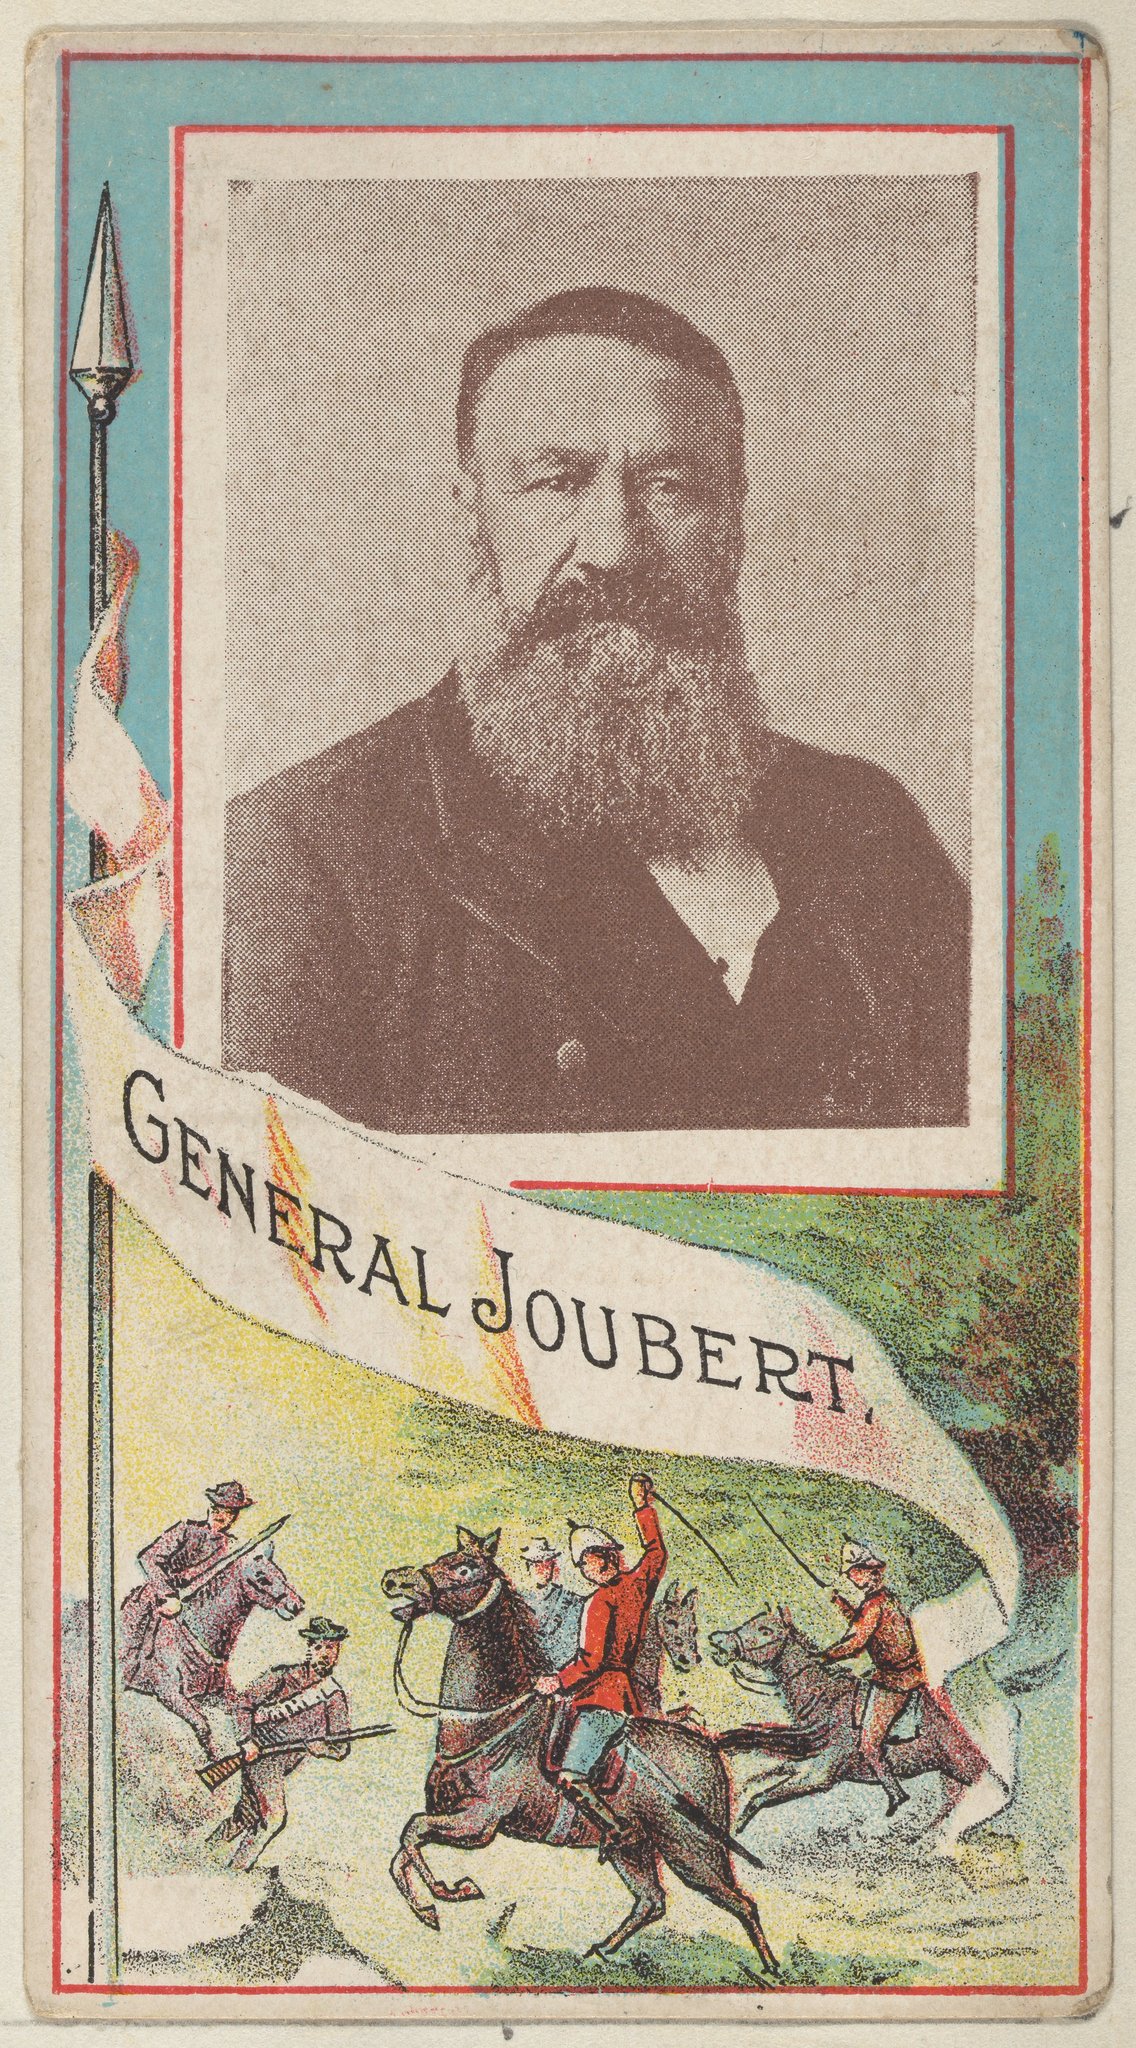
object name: print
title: General Joubert, from the "Generals" series (T64), issued by D.H. McAlpin & Co. Tobacco Company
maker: d.h. mcalpin & co. tobacco company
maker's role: publisher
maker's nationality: american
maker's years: 1857-1901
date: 1901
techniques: color lithograph